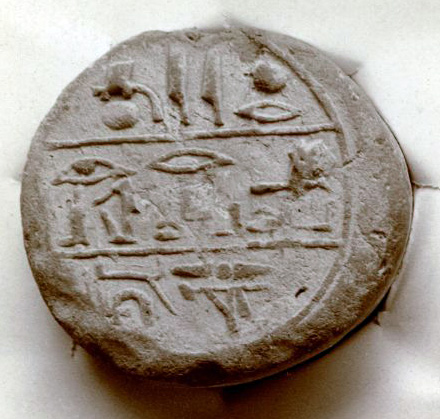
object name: cone, circular impression, min, overseer of the seal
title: Funerary Cone of the Overseer of the Seal Min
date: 1550-1295 BCE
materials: pottery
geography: egypt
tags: hieroglyphs